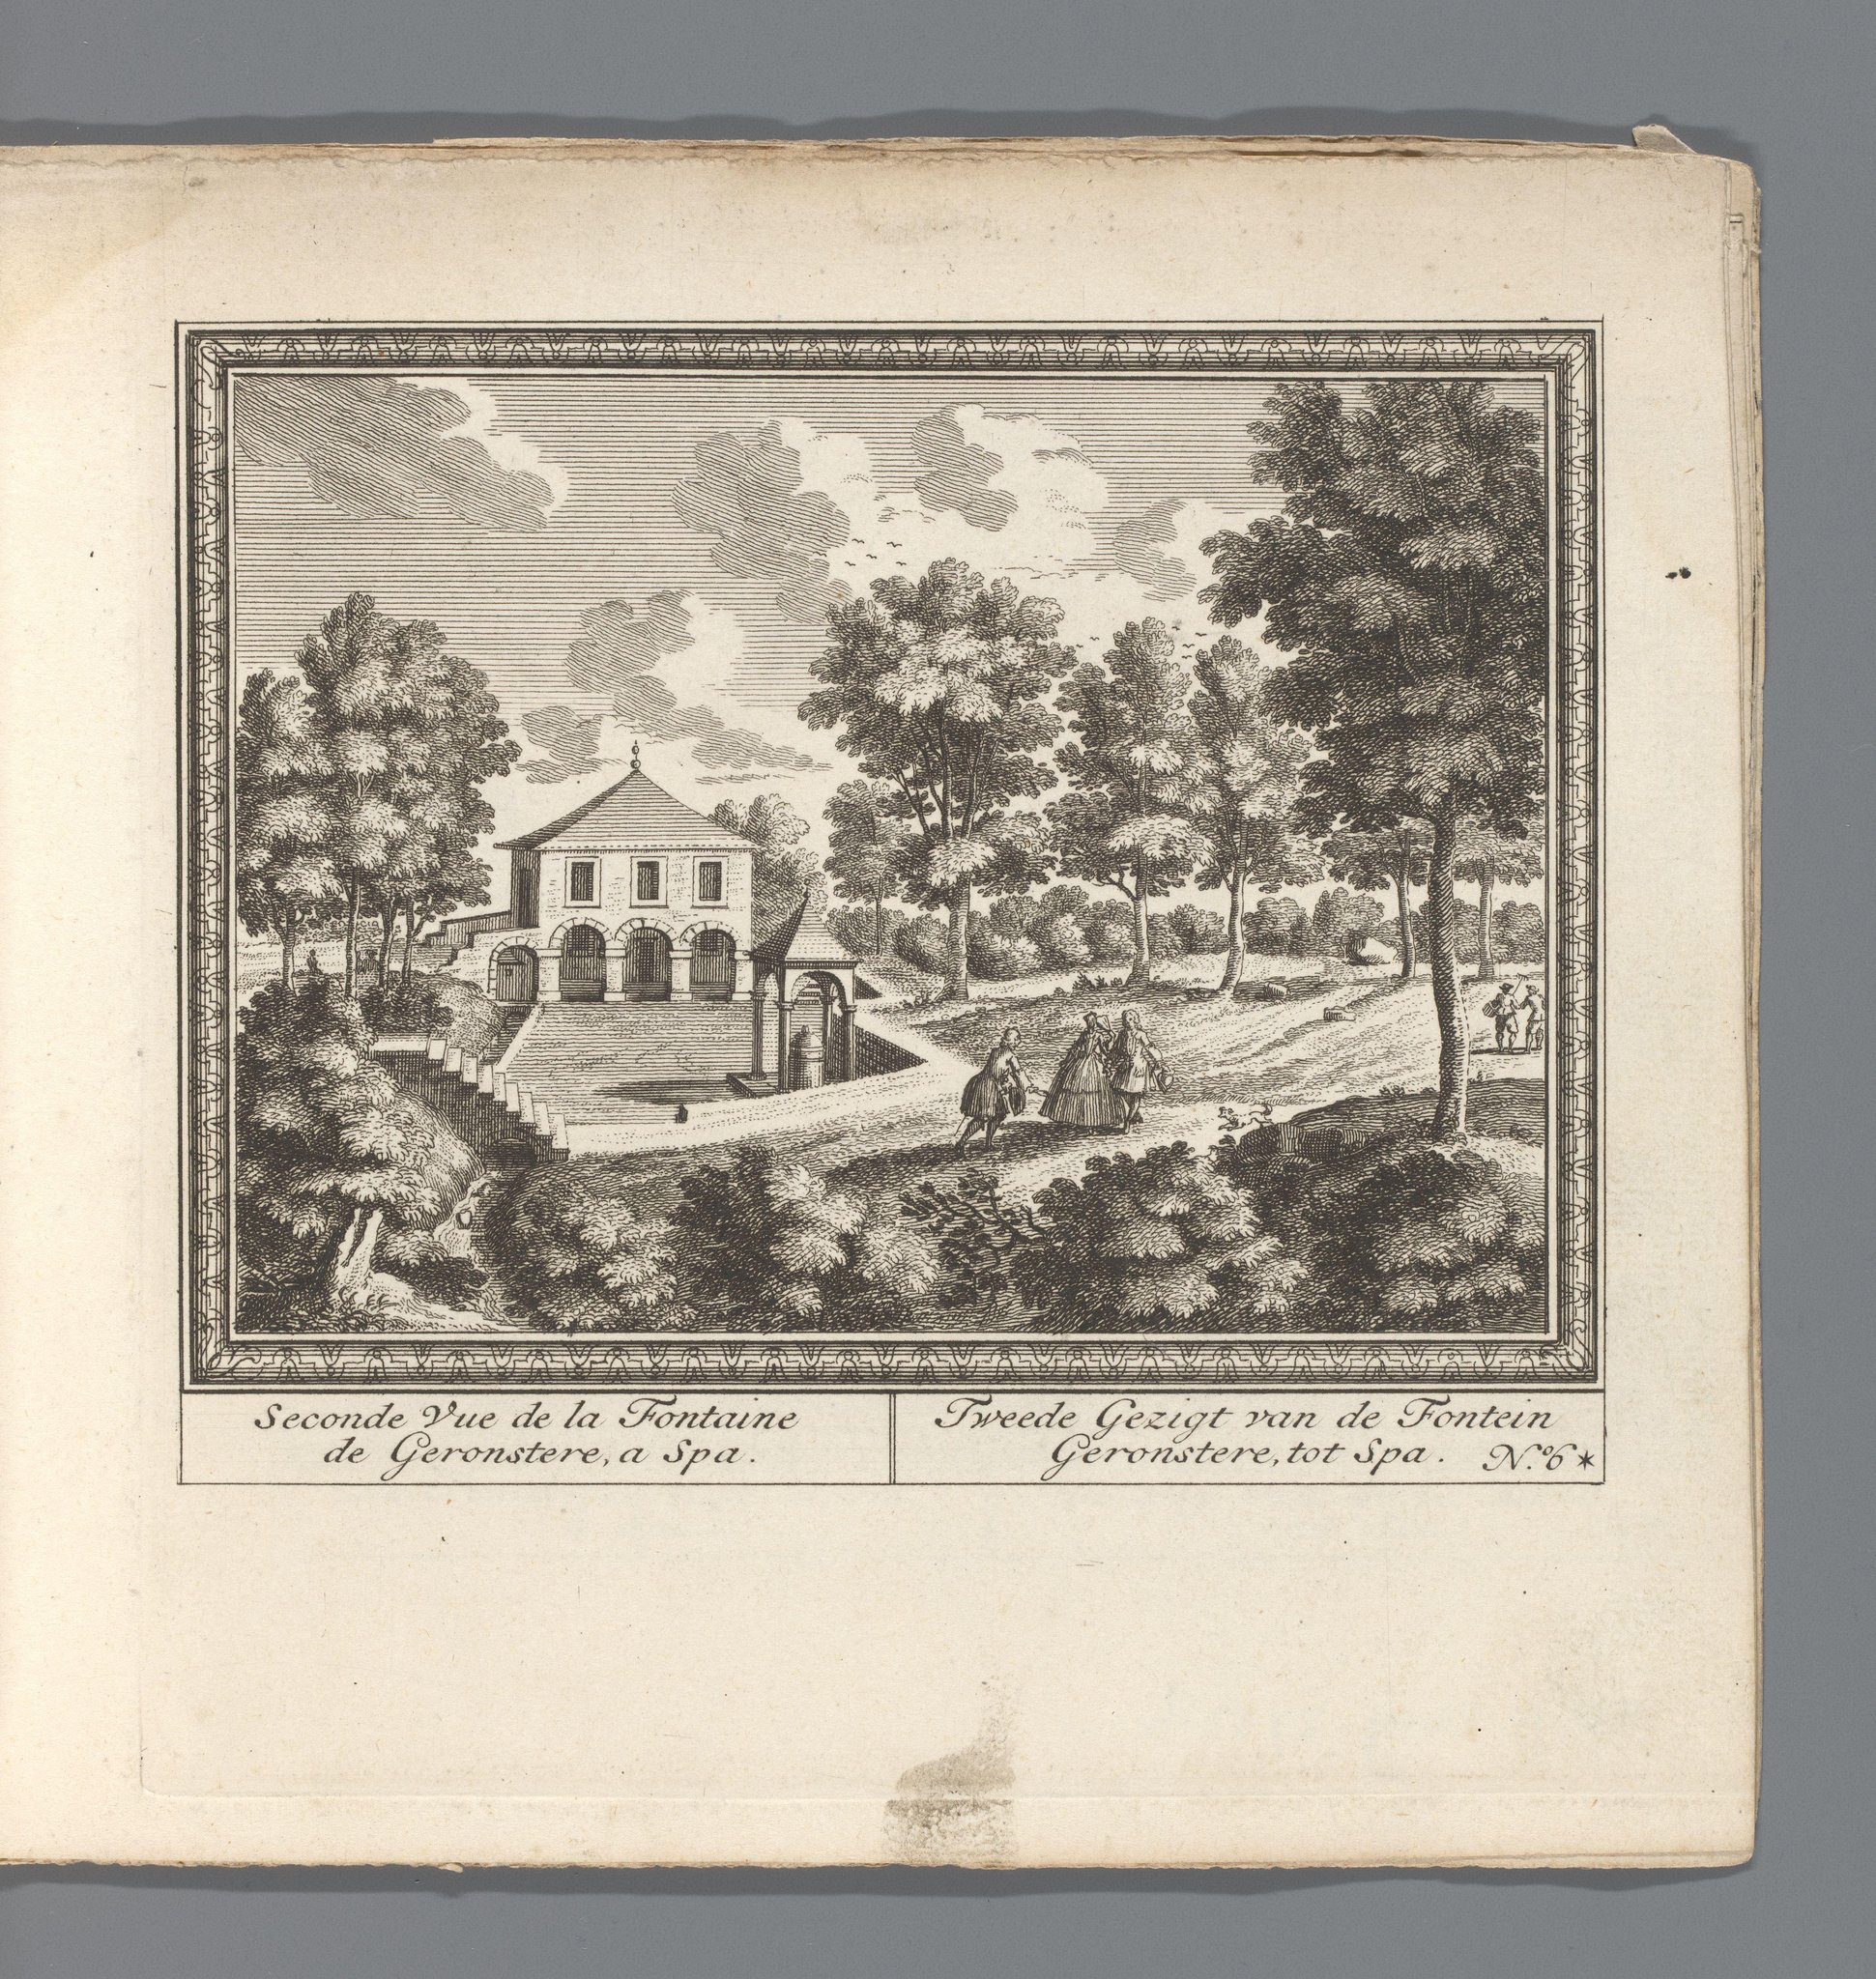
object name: print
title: Gezichten van de bronnen bij Spa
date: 1734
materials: paper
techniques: etching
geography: amsterdam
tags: city-view in general; 'veduta', mineral water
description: Deze serie prenten is gebruikt in: Pöllnitz, Charles-Louis. Amuseums des eaux de Spa. Ouvrage utile a ceux qui vont boire ces eaux minérales sur les lieux. 2 dln. Amsterdam: Pieter Mortier, 1734. In deze uitgave zijn de prenten echter gevouwen. Mogelijk is deze serie een losse uitgave van de prenten. Er ontbreekt één prent die in het boek is opgenomen (nr. 4), waarop geen landschap is afgebeeld.